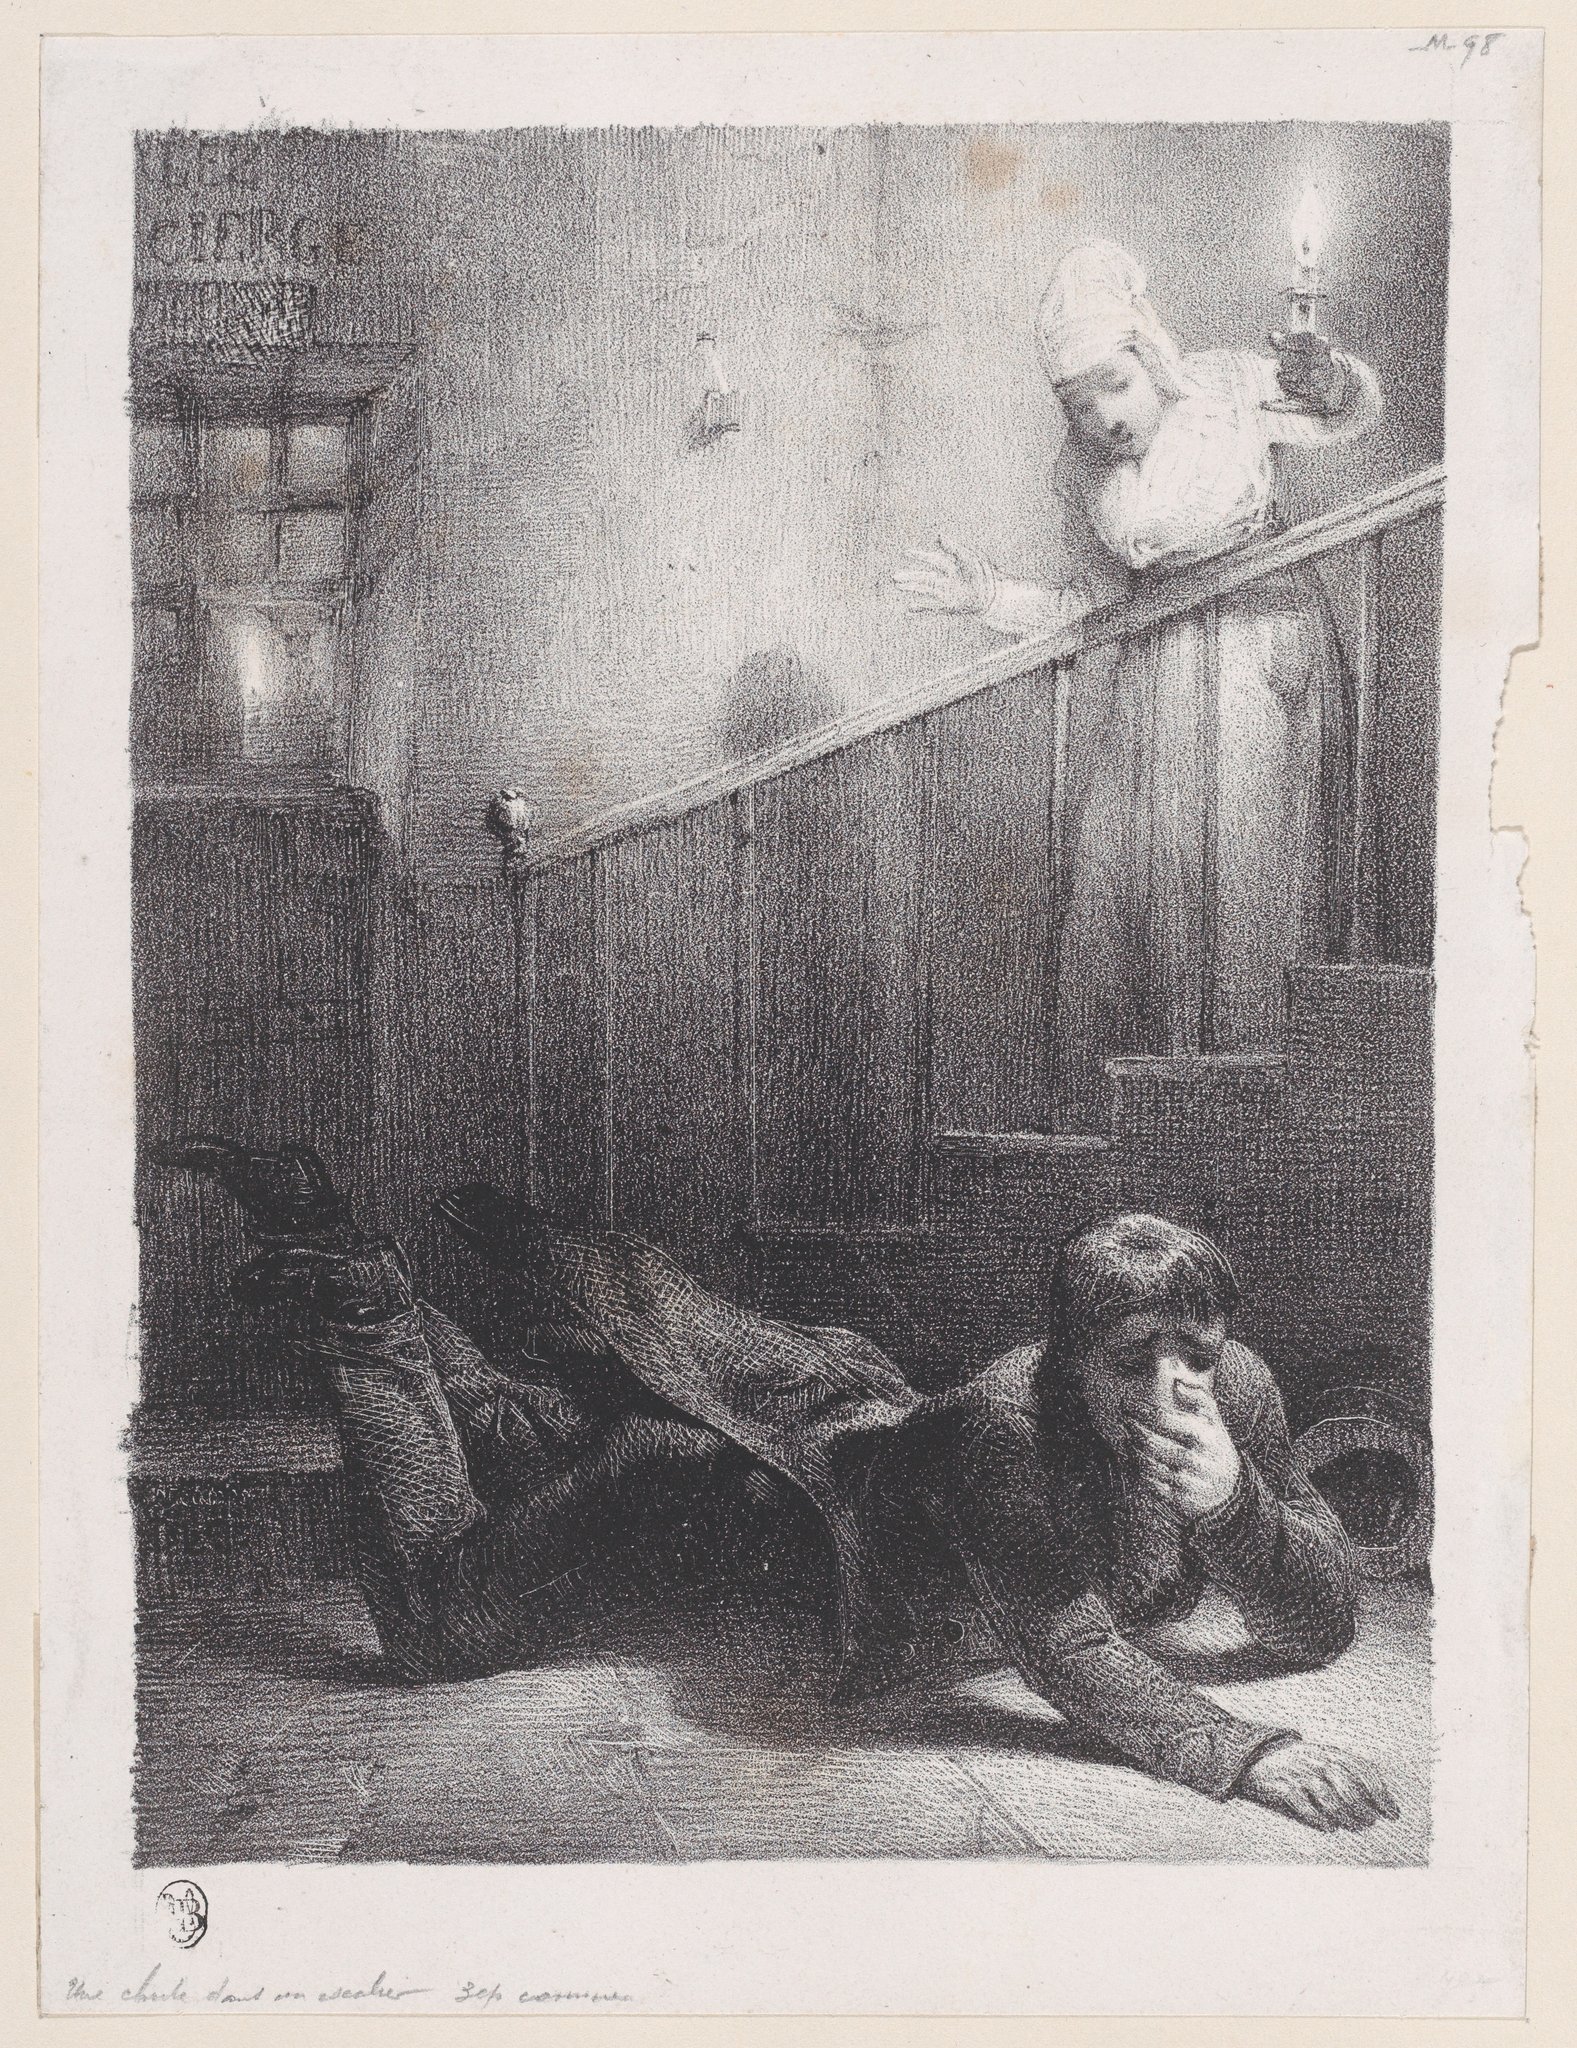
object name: print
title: A Fall Down the Stairs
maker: alexandre-gabriel decamps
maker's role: artist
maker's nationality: french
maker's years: 1803-1860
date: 1834-1835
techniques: lithograph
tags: stairs,men,women